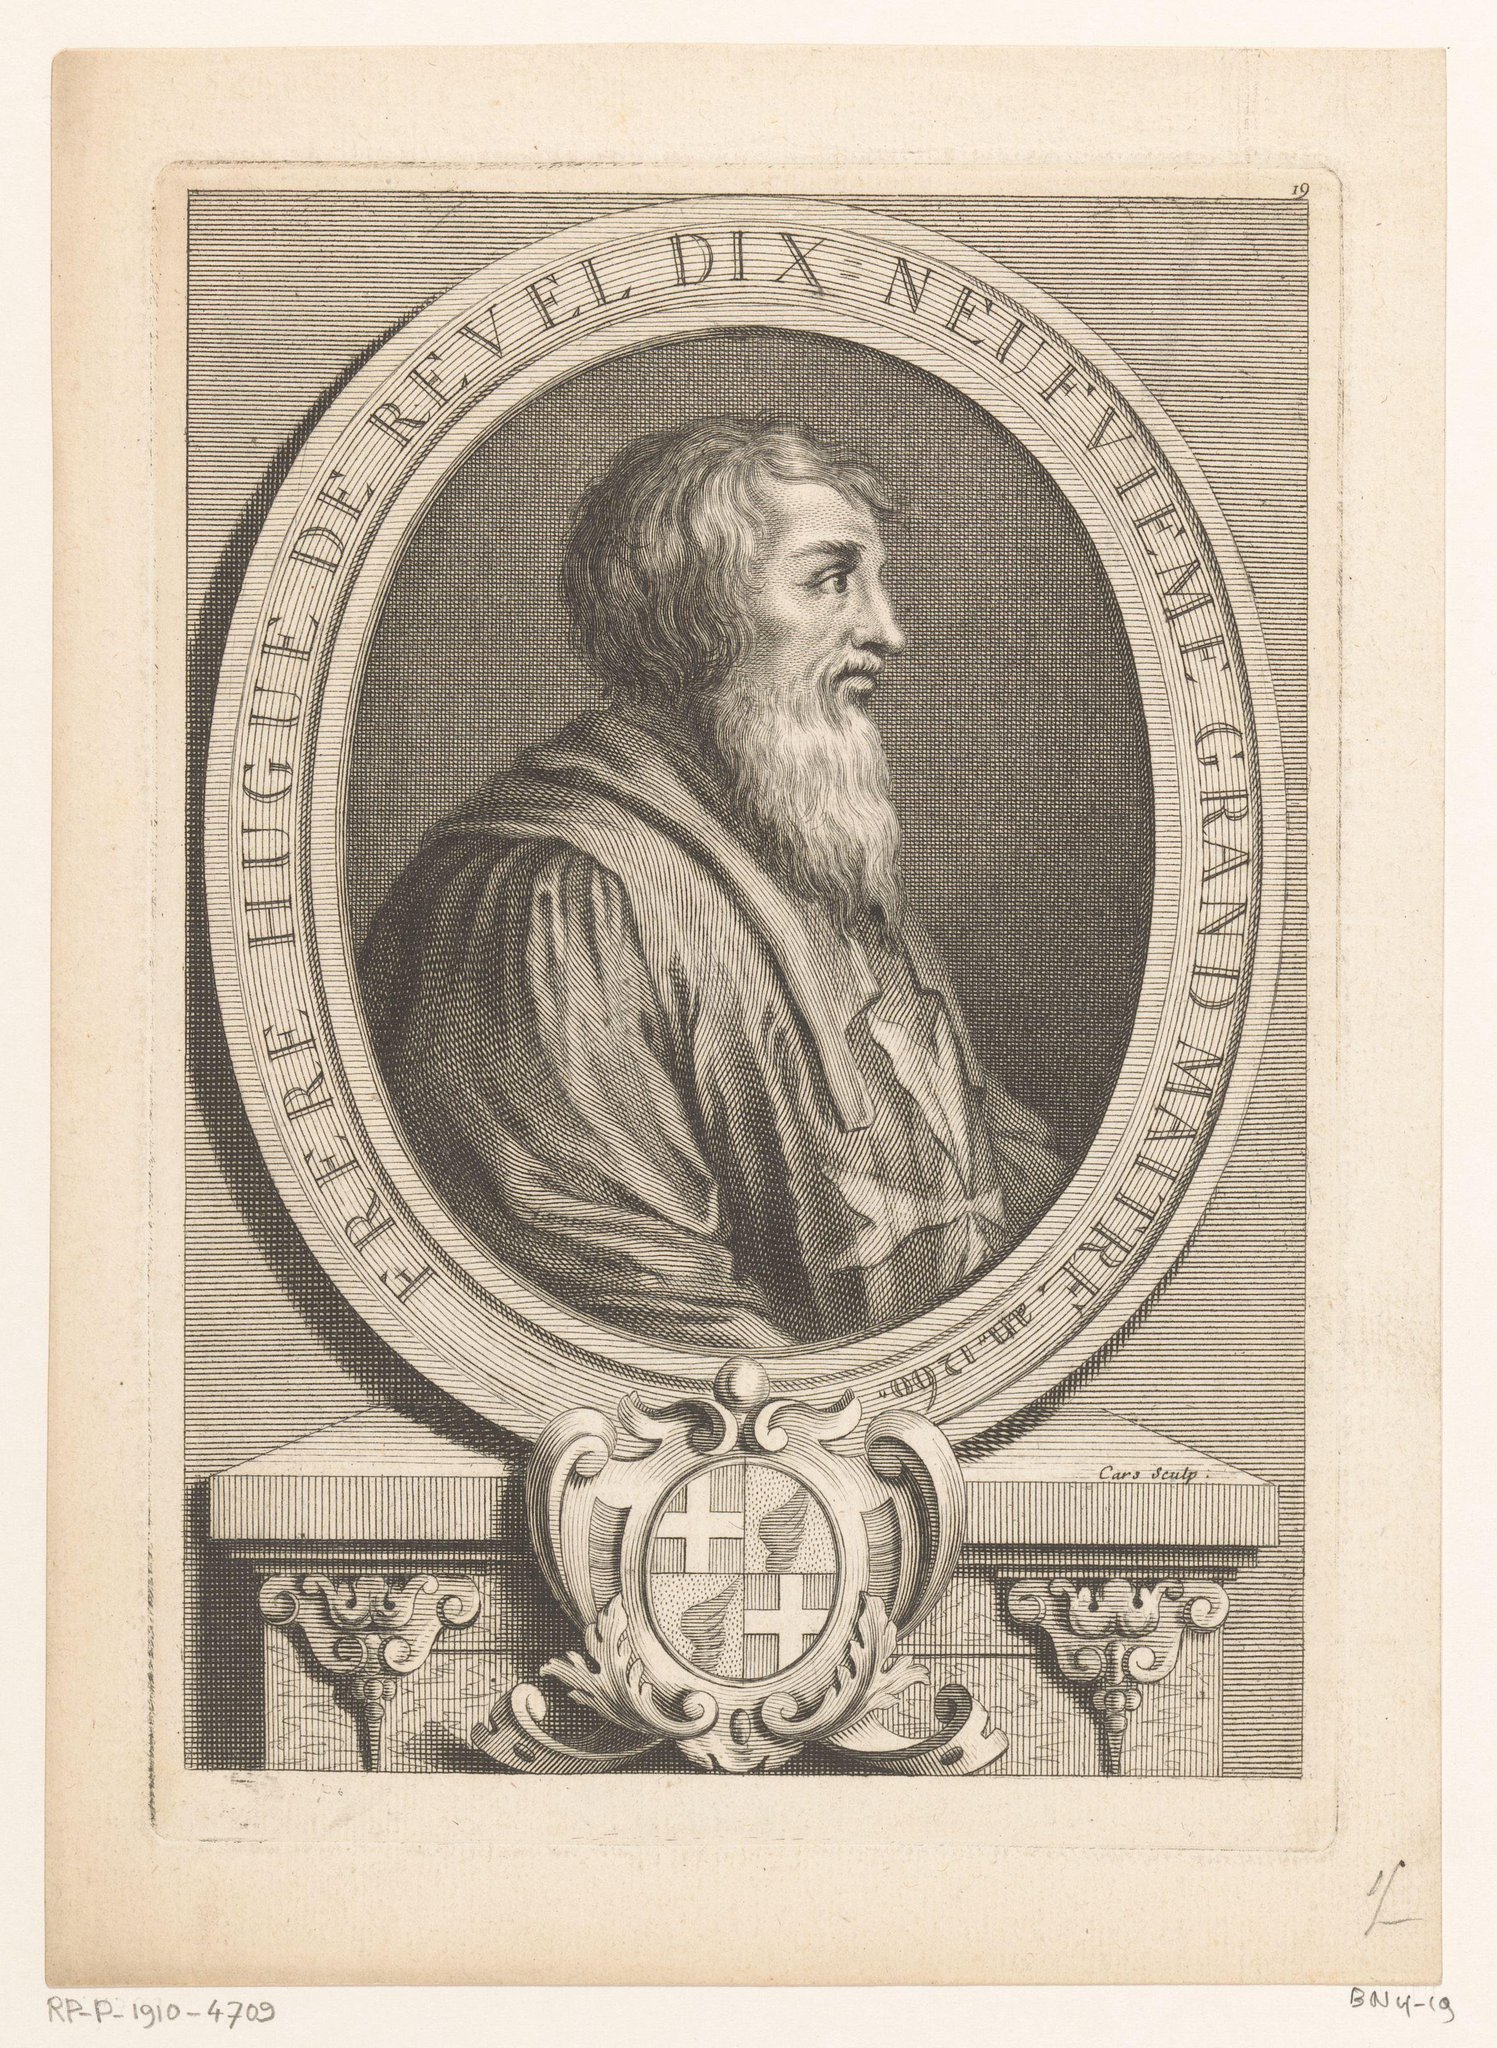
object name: book illustration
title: Portret van Hugues de Revel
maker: laurent cars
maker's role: print maker, publisher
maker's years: 1699-1771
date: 1726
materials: paper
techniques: engraving, etching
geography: france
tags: historical persons, military orders, e.g.: knights templars, knights of malta, teutonic knights ~ roman catholic church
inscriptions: collector's mark: Lugt 2228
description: Prent uit: Vertot, René Aubert de. Histoire des Chevaliers hospitaliers de St Jean de Jérusalem. Parijs: Rollin, Quillau, Desaint, 1726. Illustratie op p. 402 van deel 1. Cars vervaardigde portretten van 65 grootmeesters van de Maltezer Orde.